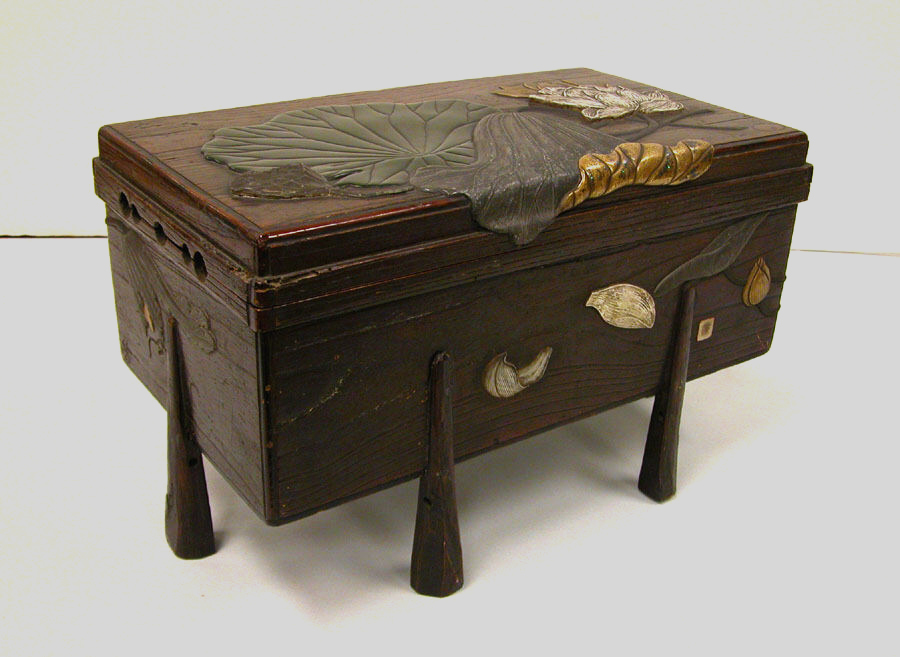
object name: sutra chest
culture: japanese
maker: mochizuki hanzan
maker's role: artist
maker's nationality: japanese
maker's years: 1743-1790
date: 1701-1800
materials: ceramic, gold, lacquer, wood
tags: lotuses,leaves,chests